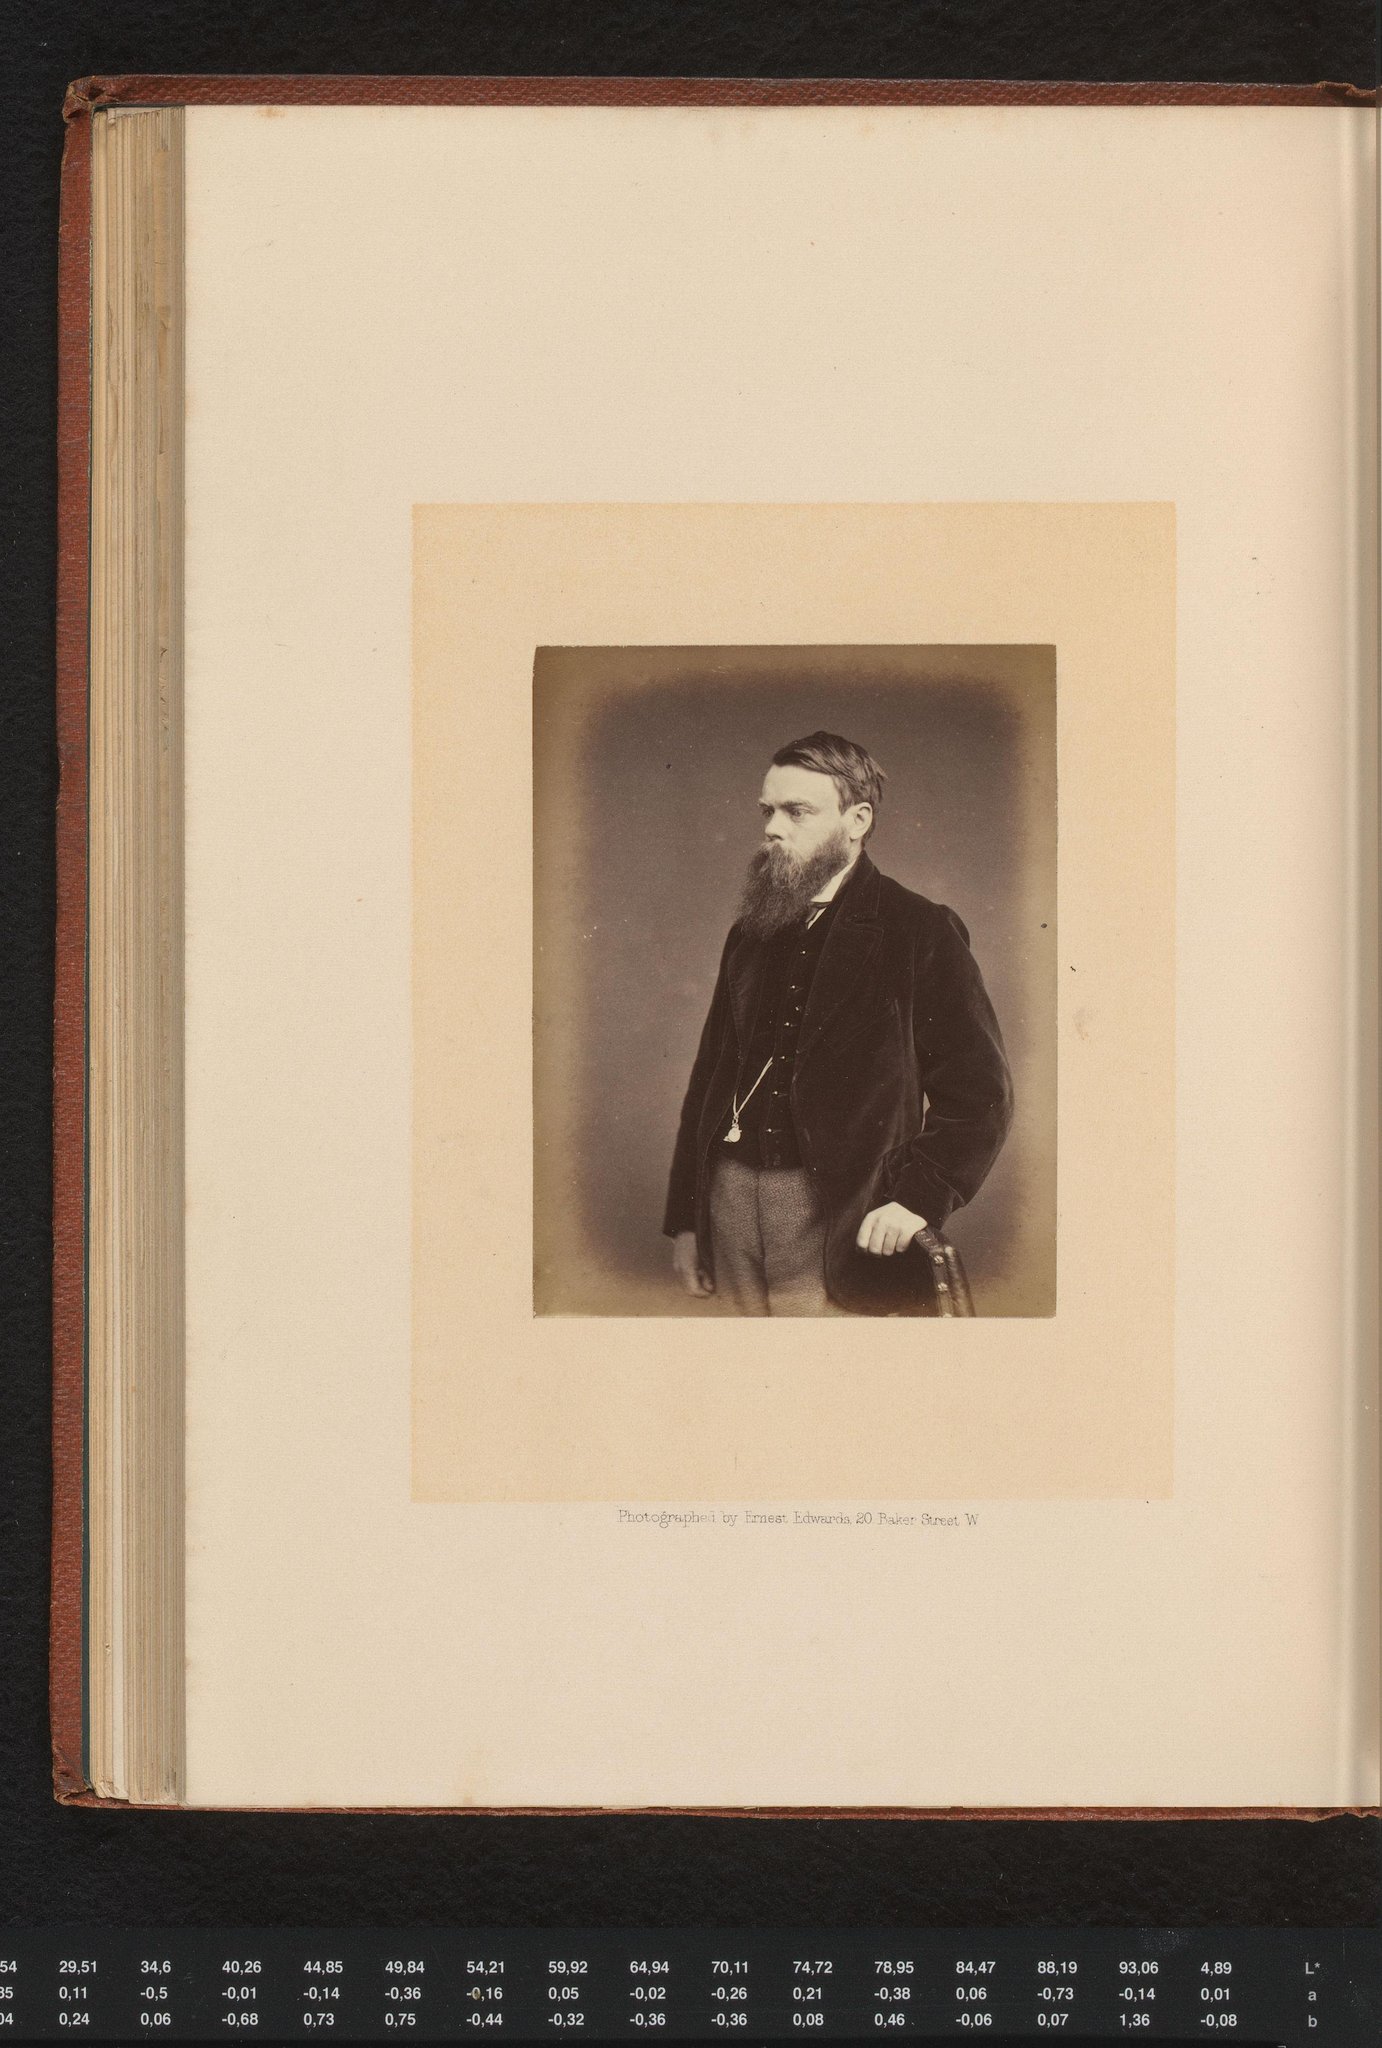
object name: page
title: Portret van de romanschrijver Henry Kingsley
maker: ernest edwards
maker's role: fotograaf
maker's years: 1837-1903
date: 1862-1867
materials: paper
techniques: albumen print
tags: portrait of a writer